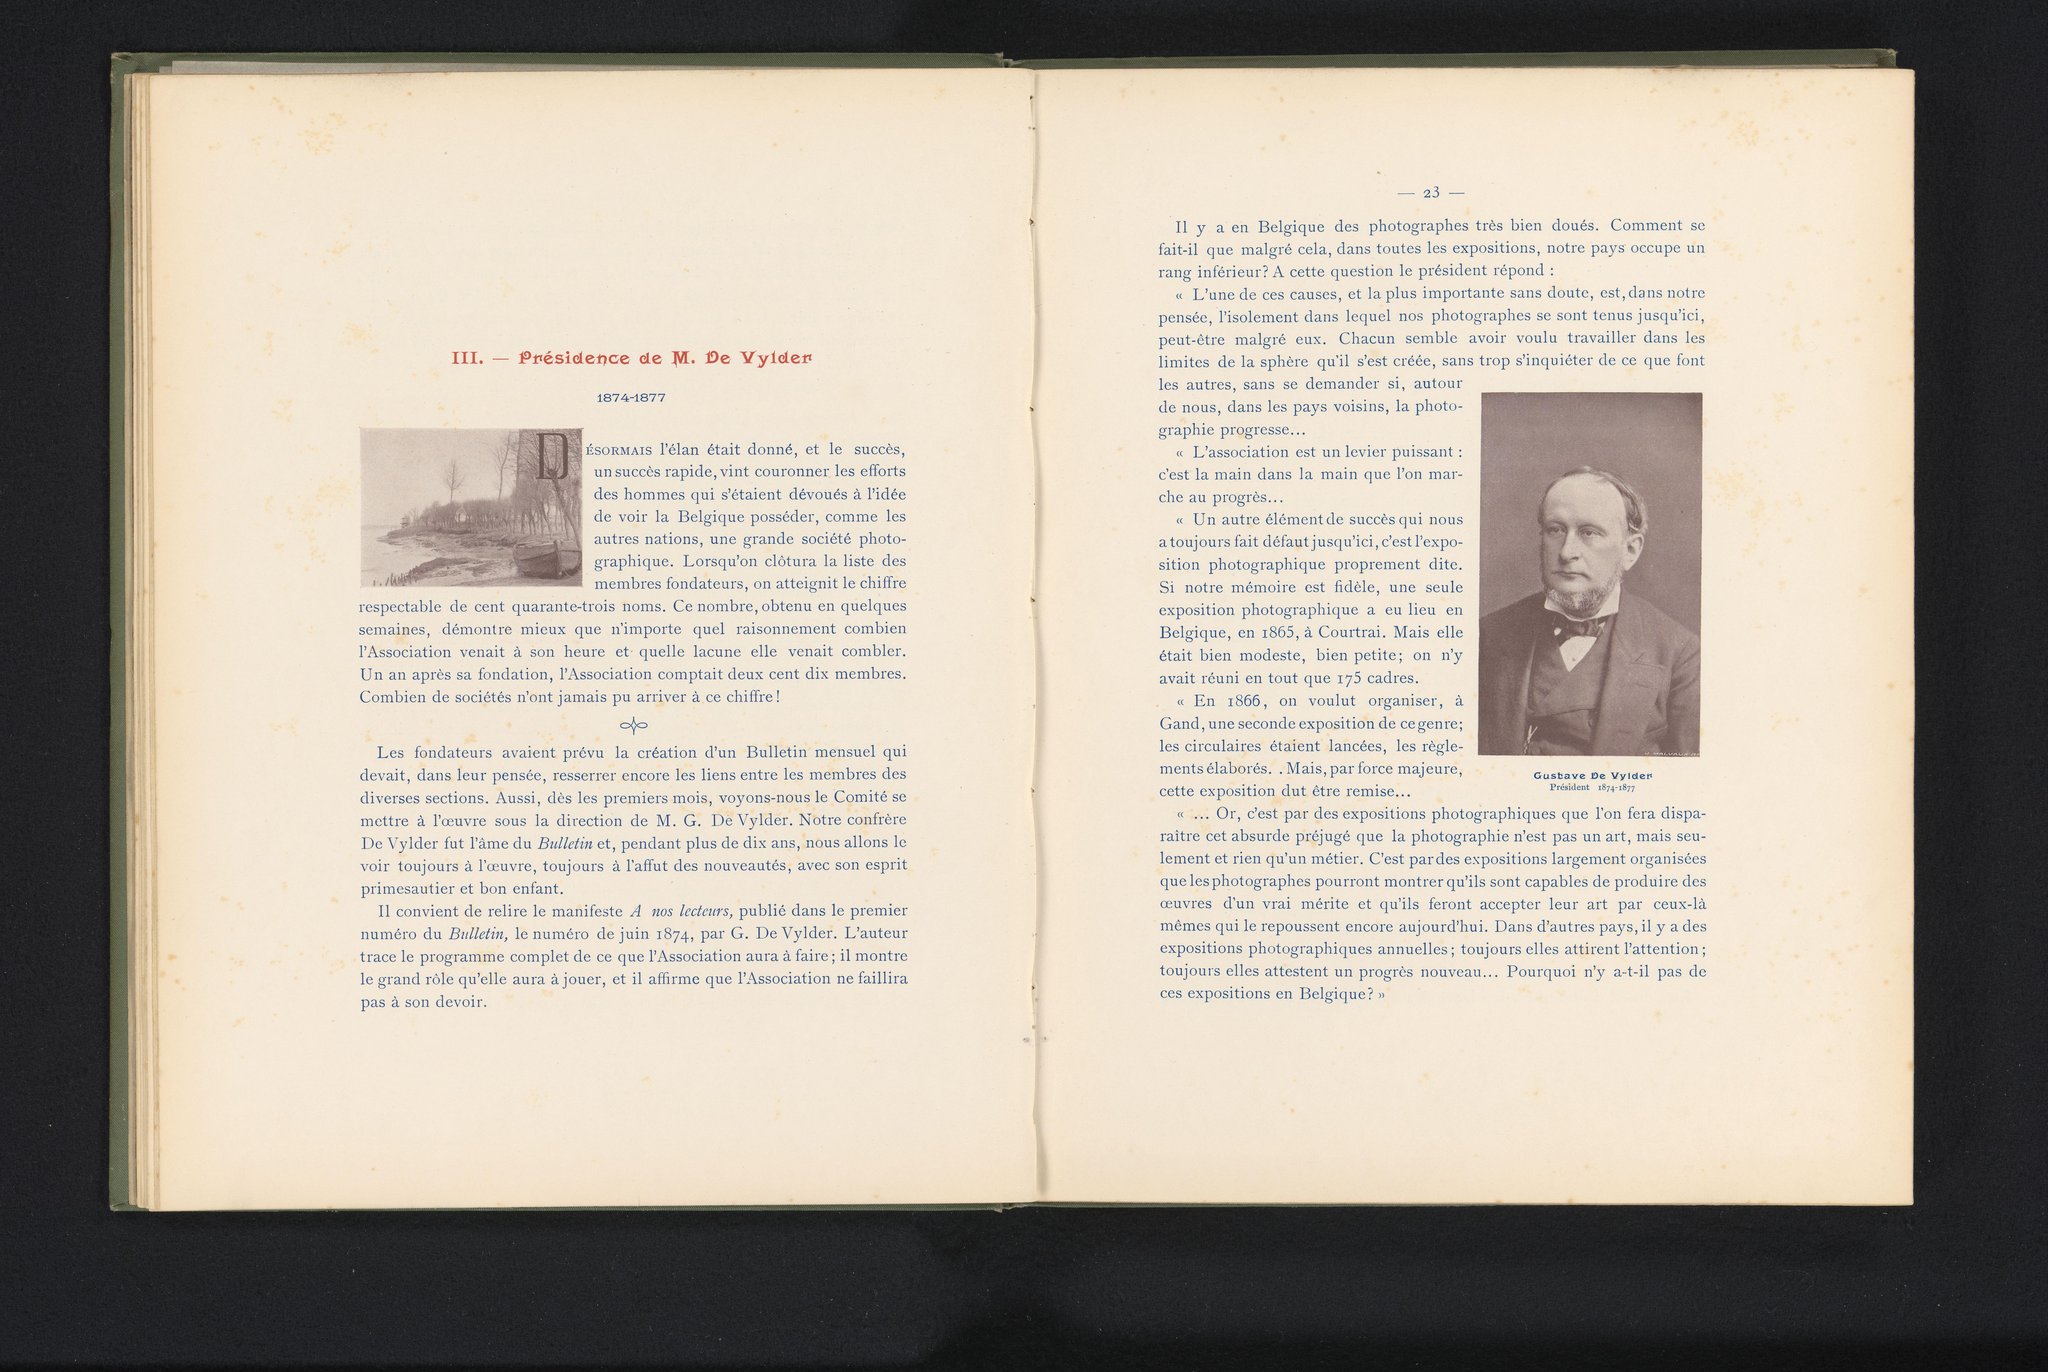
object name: photomechanical print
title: Landschap met roeiboot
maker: Anonymous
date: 1893-1898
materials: paper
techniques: autotype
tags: landscapes, rowing-boat, canoe, etc.